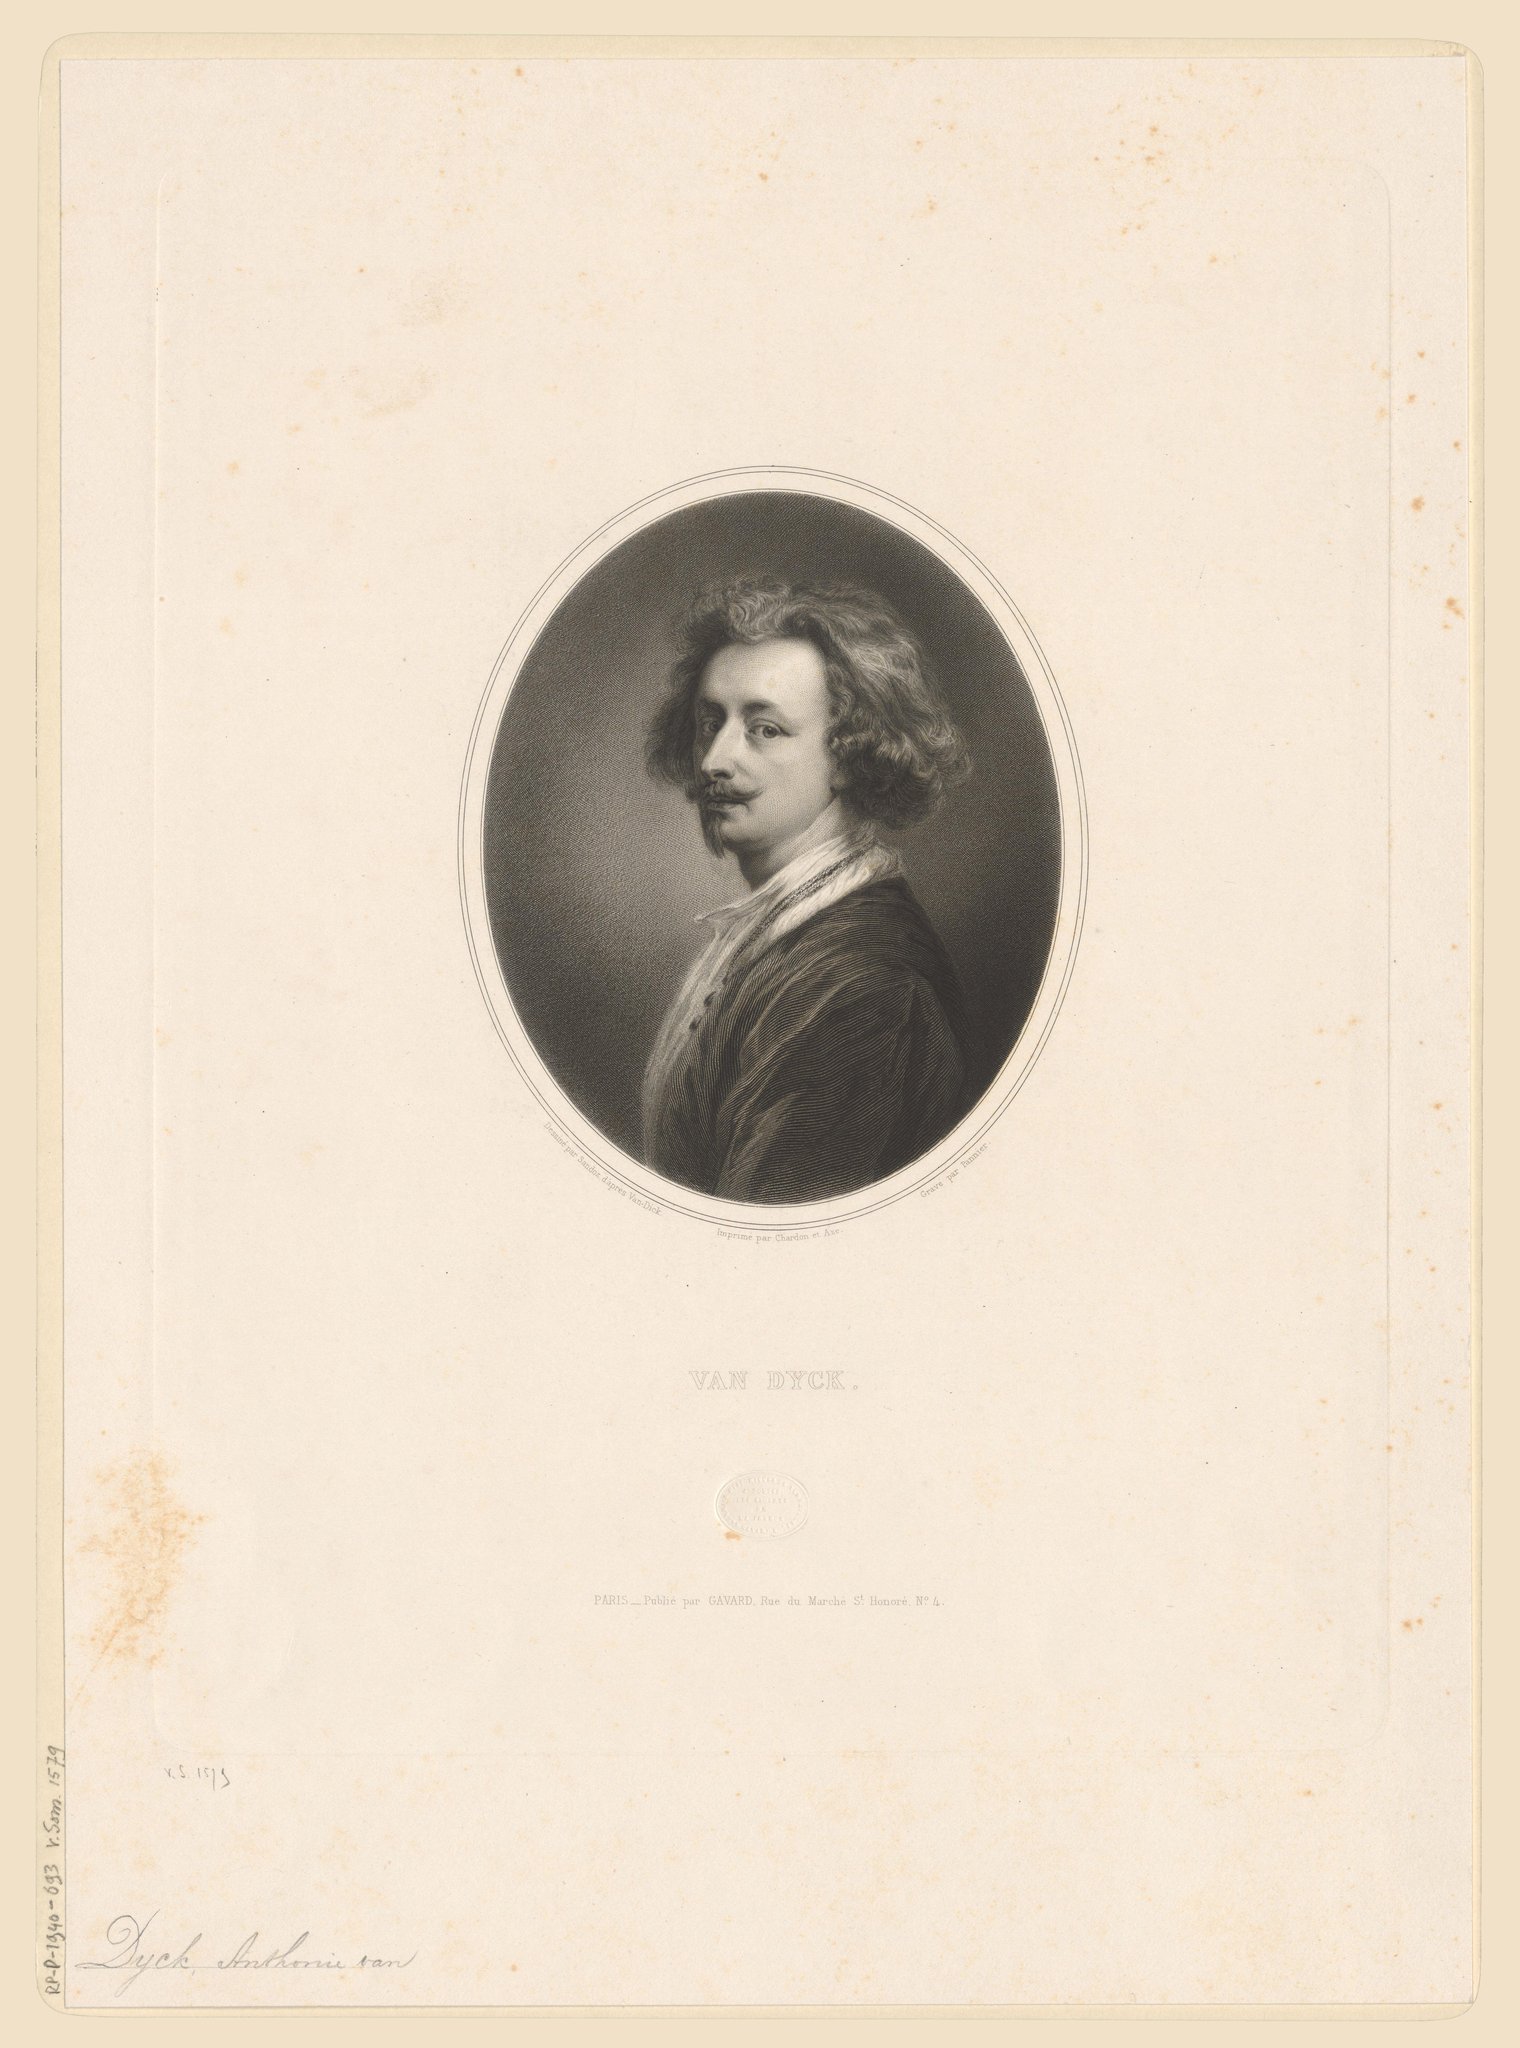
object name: print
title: Historische galerij van Versailles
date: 1835-1851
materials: paper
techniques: engraving, etching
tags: antwerp, london, painter, print maker, draughtsman, anthony van dyck, historical persons, portrait, self-portrait of painter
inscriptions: collector's mark: Lugt 2760, collector's mark: Lugt 2228, check stamp: Lugt 4369